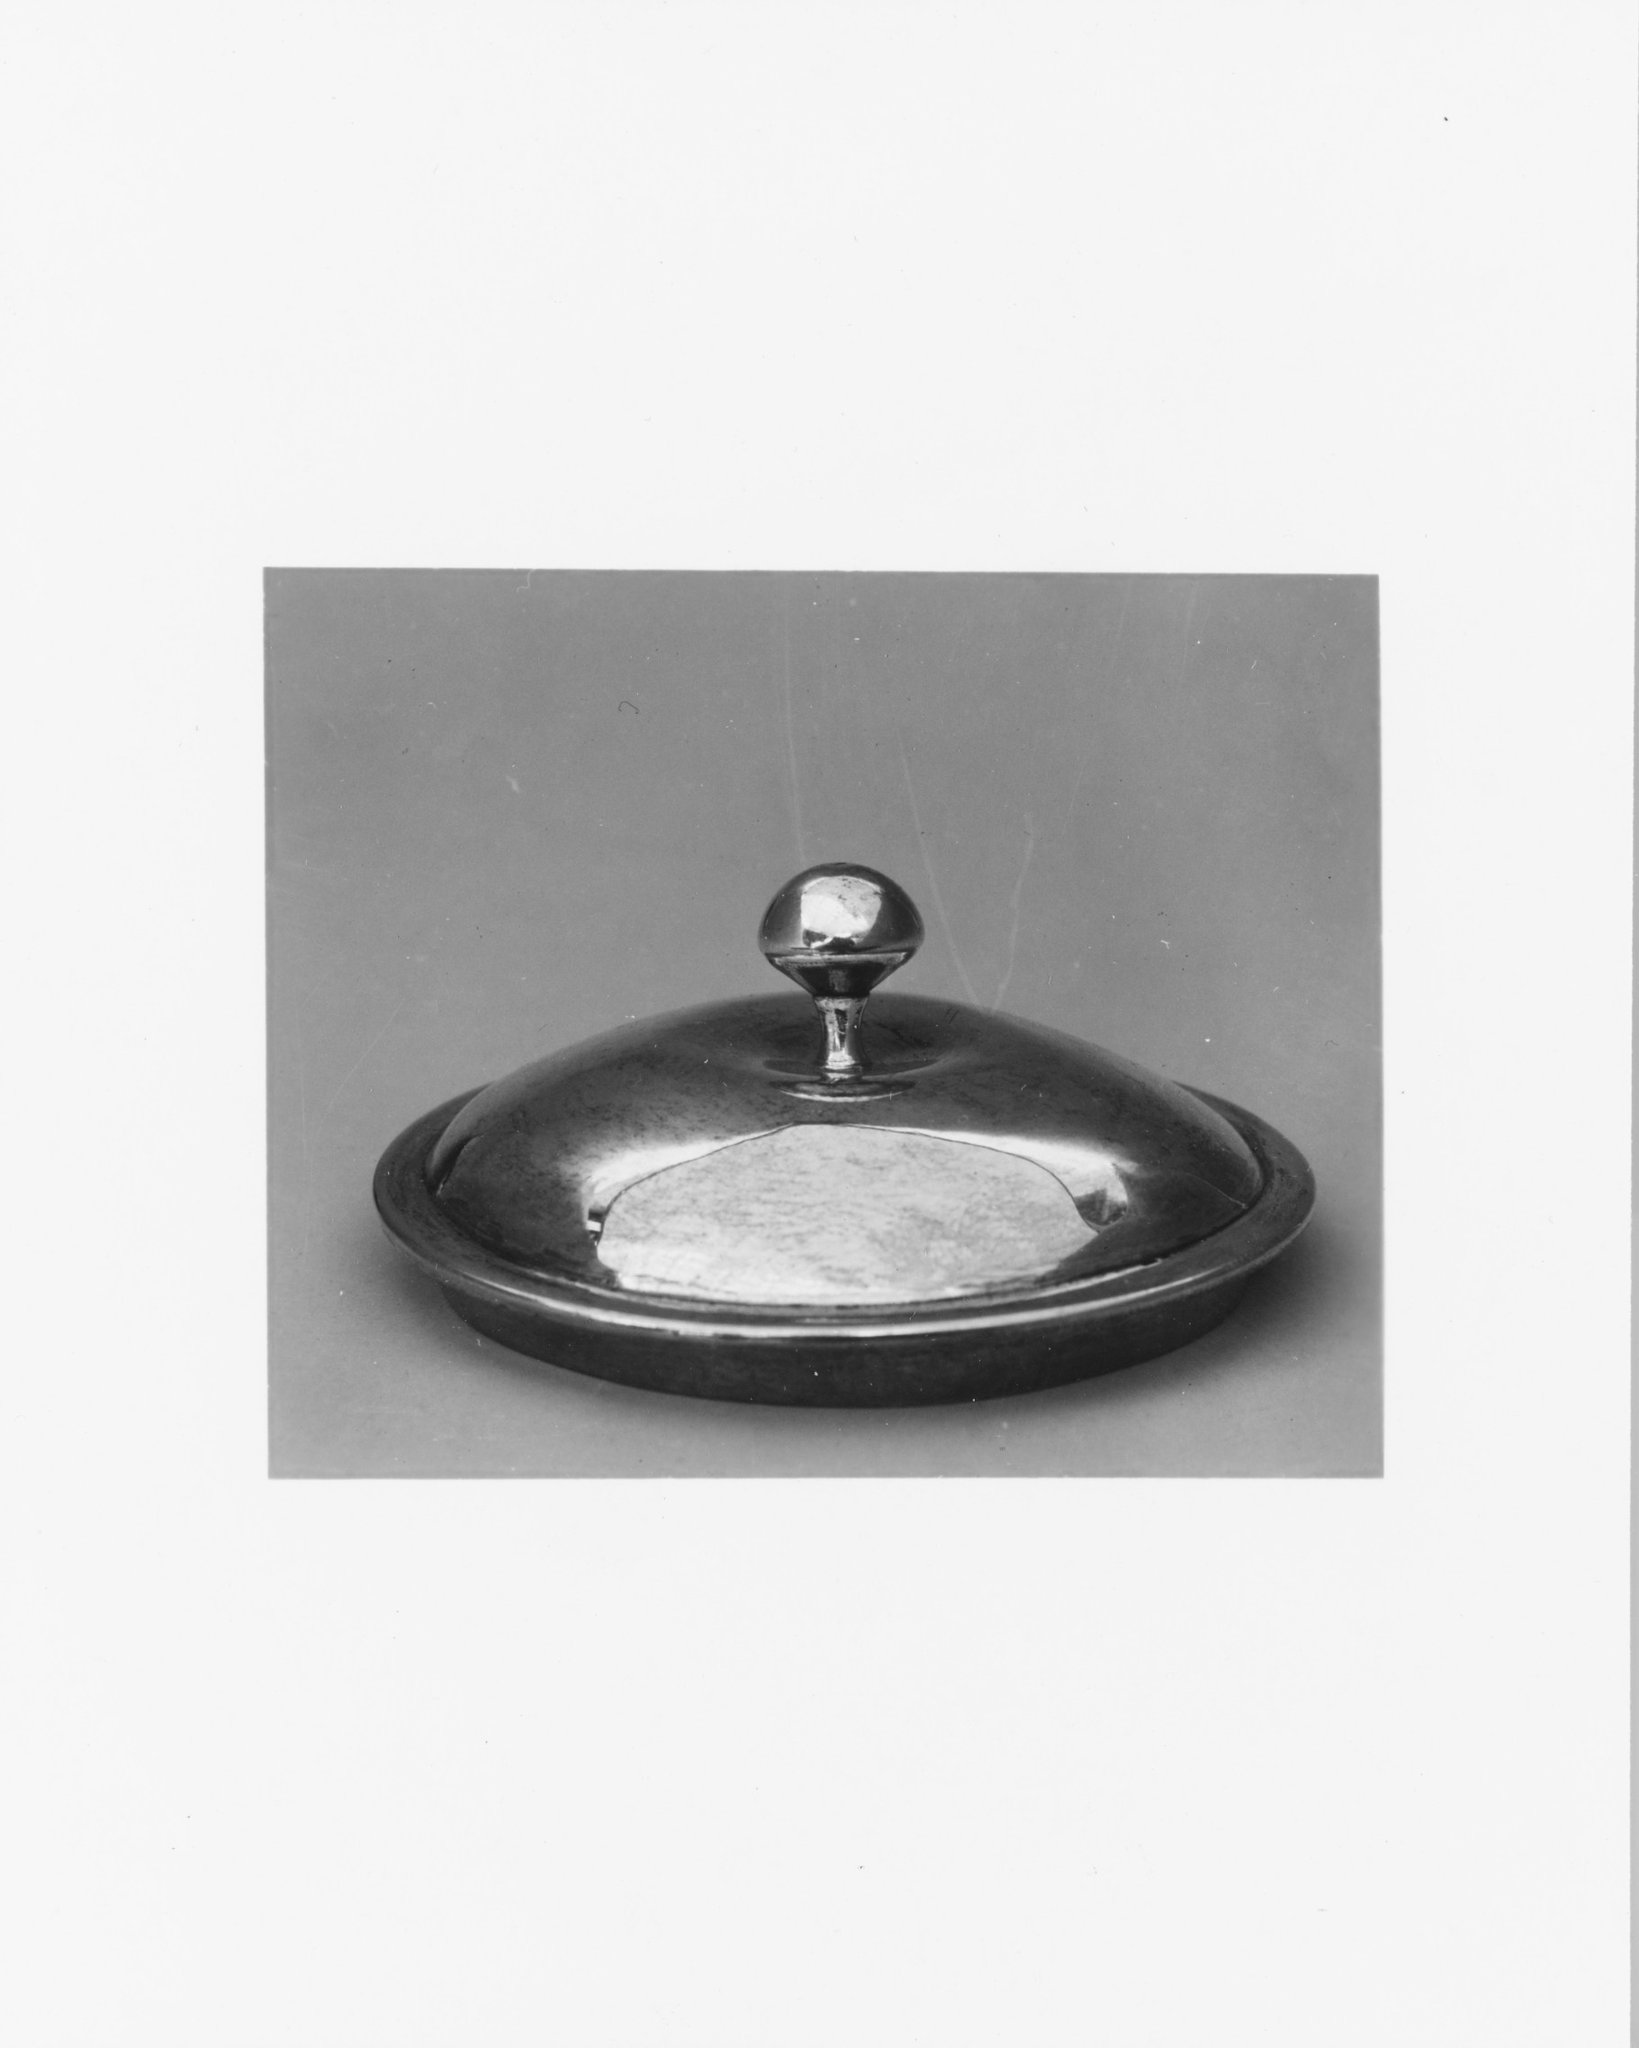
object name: cover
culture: american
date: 1800-1900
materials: silver